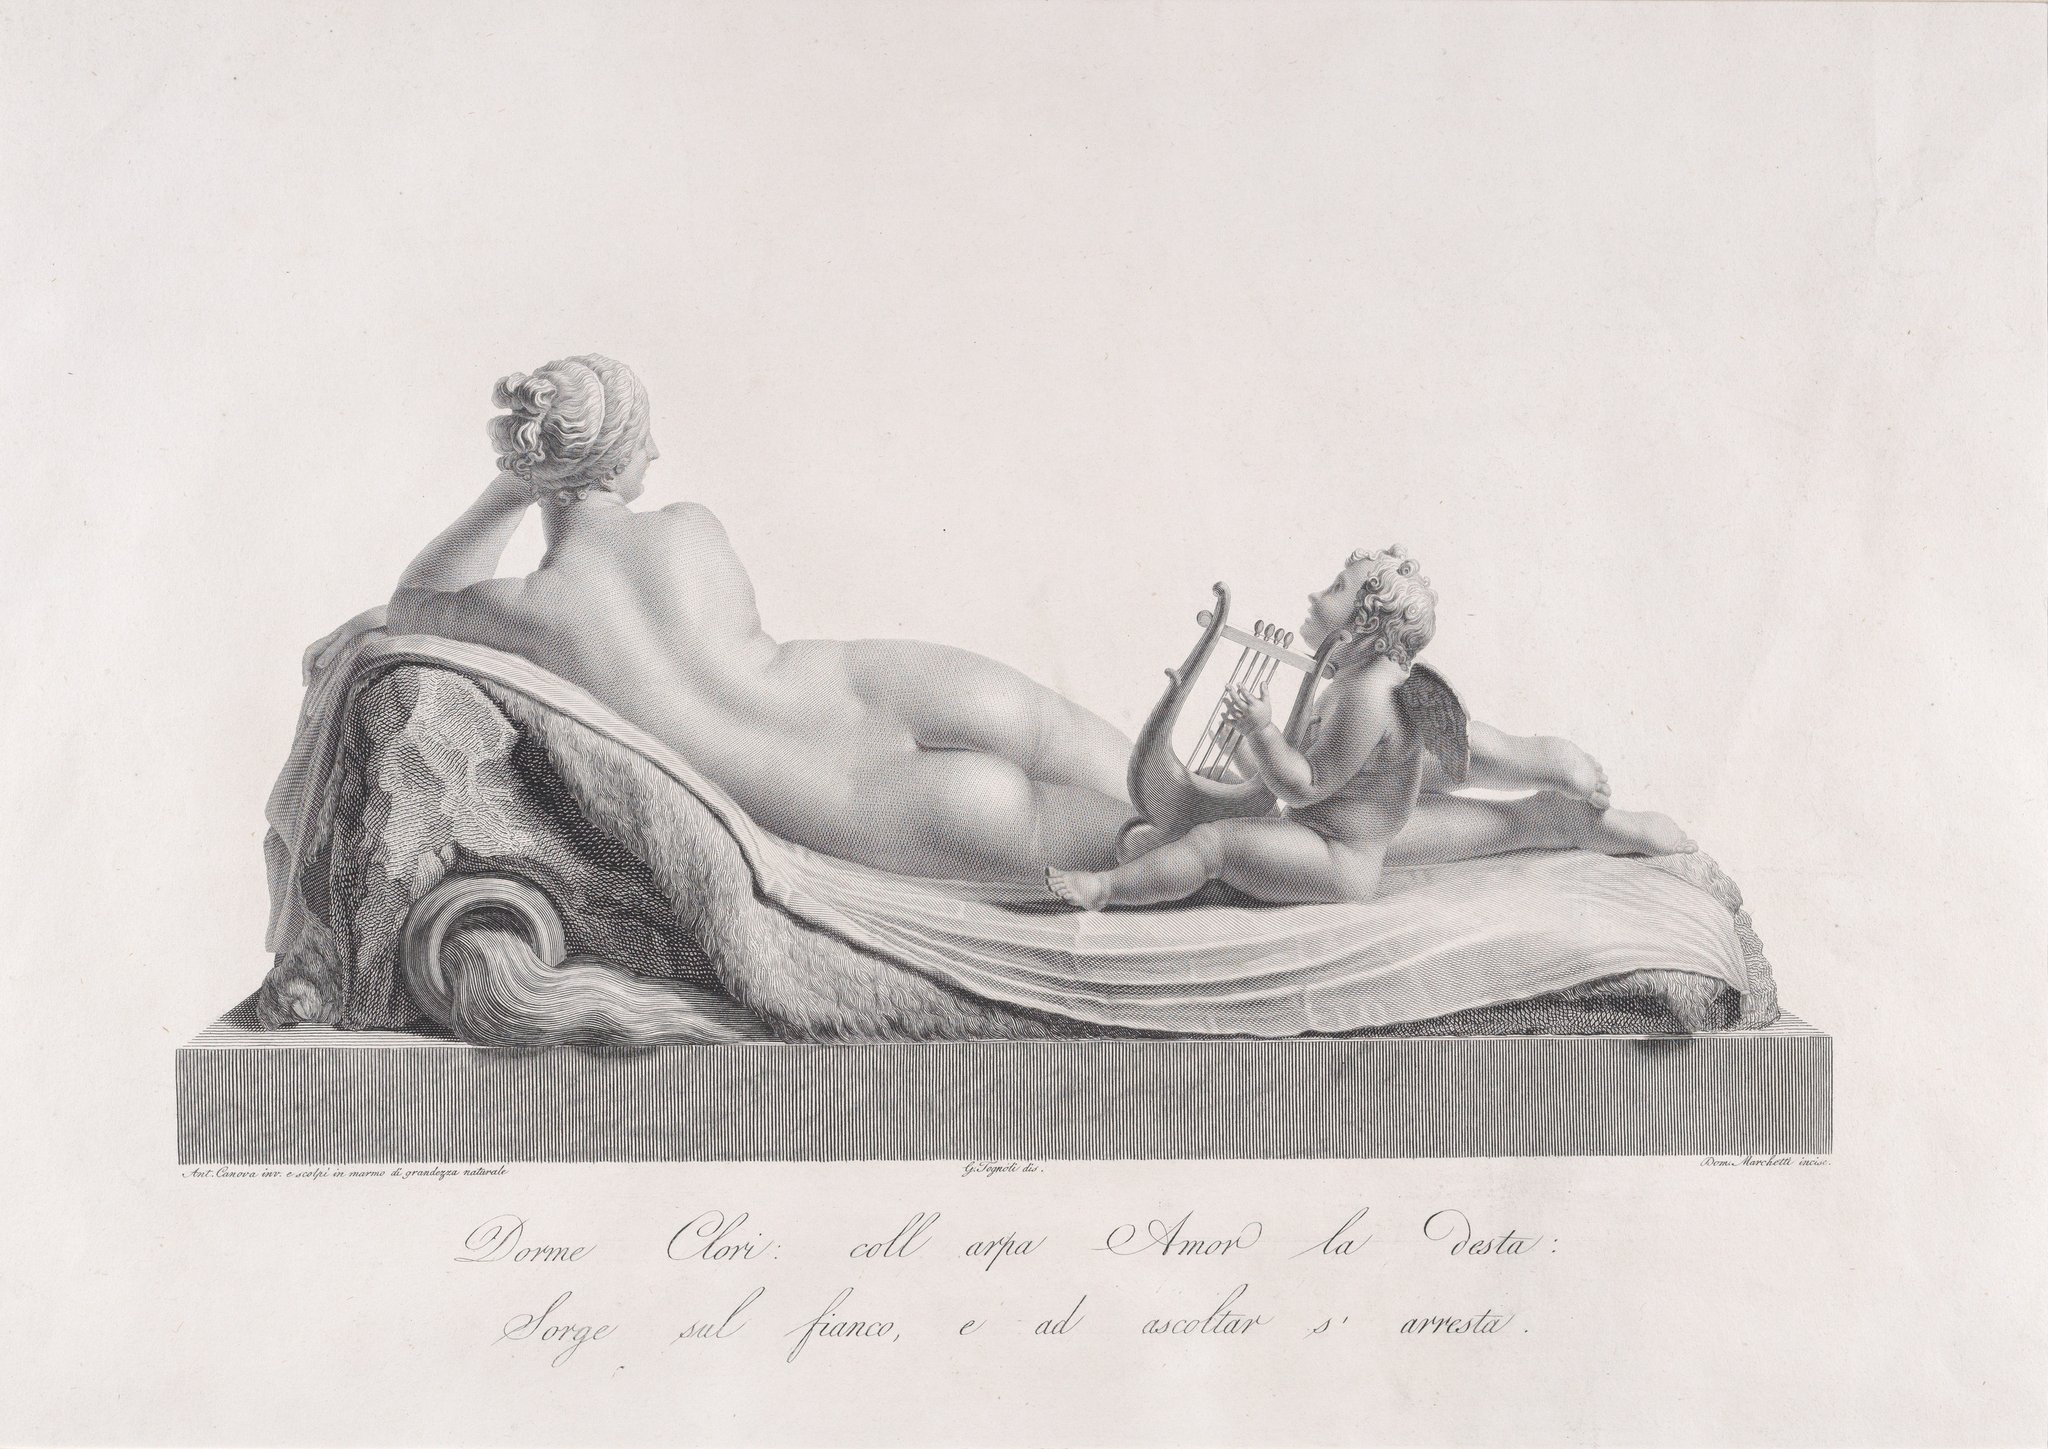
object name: print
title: Back view of Venus reclining accompanied by Cupid with a harp, from "Oeuvre de Canova: Recueil de Statues..."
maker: domenico marchetti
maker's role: artist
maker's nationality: italian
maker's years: 1780-1844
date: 1817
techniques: engraving, etching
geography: rome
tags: female nudes,cupid,venus